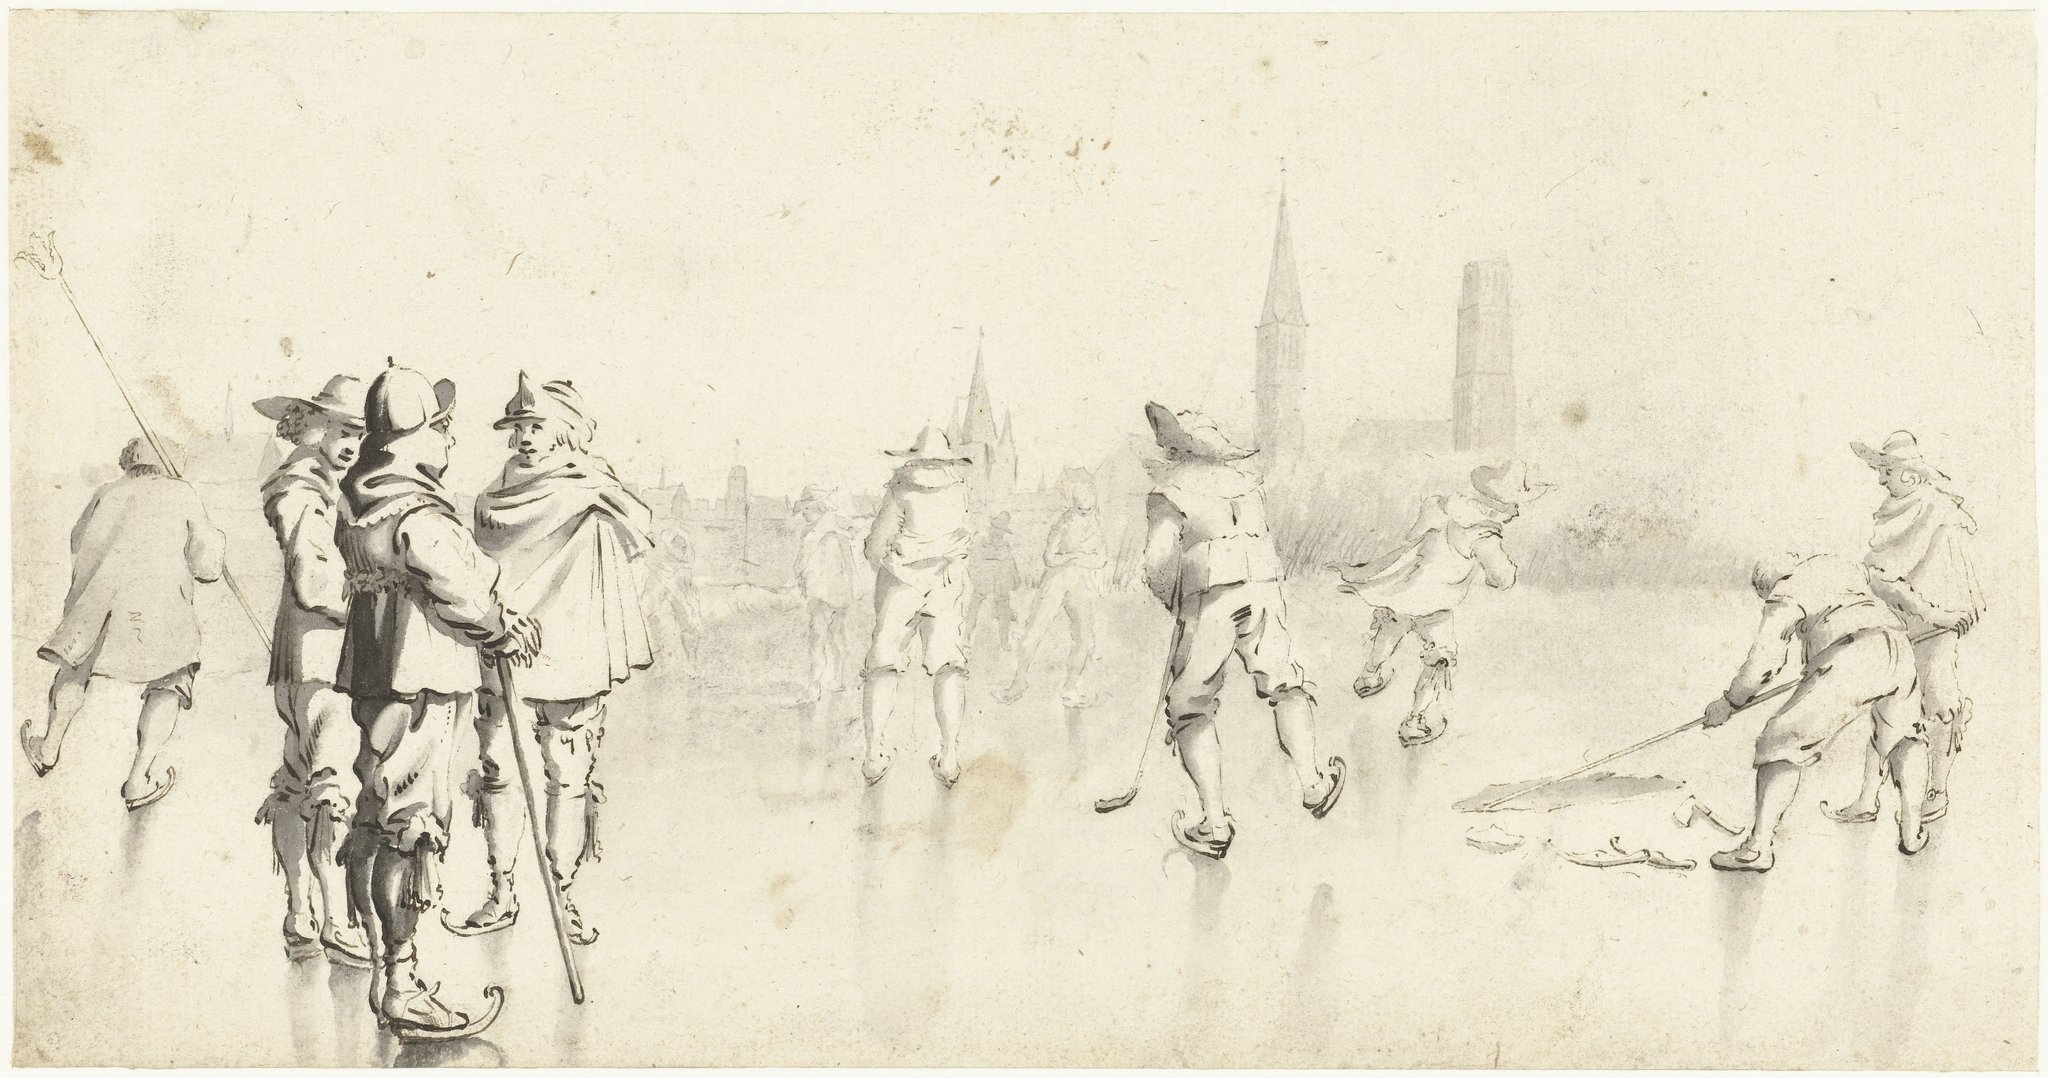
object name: drawing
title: Schaatsers buiten Zwolle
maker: gerard ter borch (ii)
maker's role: draughtsman, painter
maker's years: 1617-1681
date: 1610-1640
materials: ink, paper, pencil, watercolor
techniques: brush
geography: zwolle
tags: skates (winter sports)